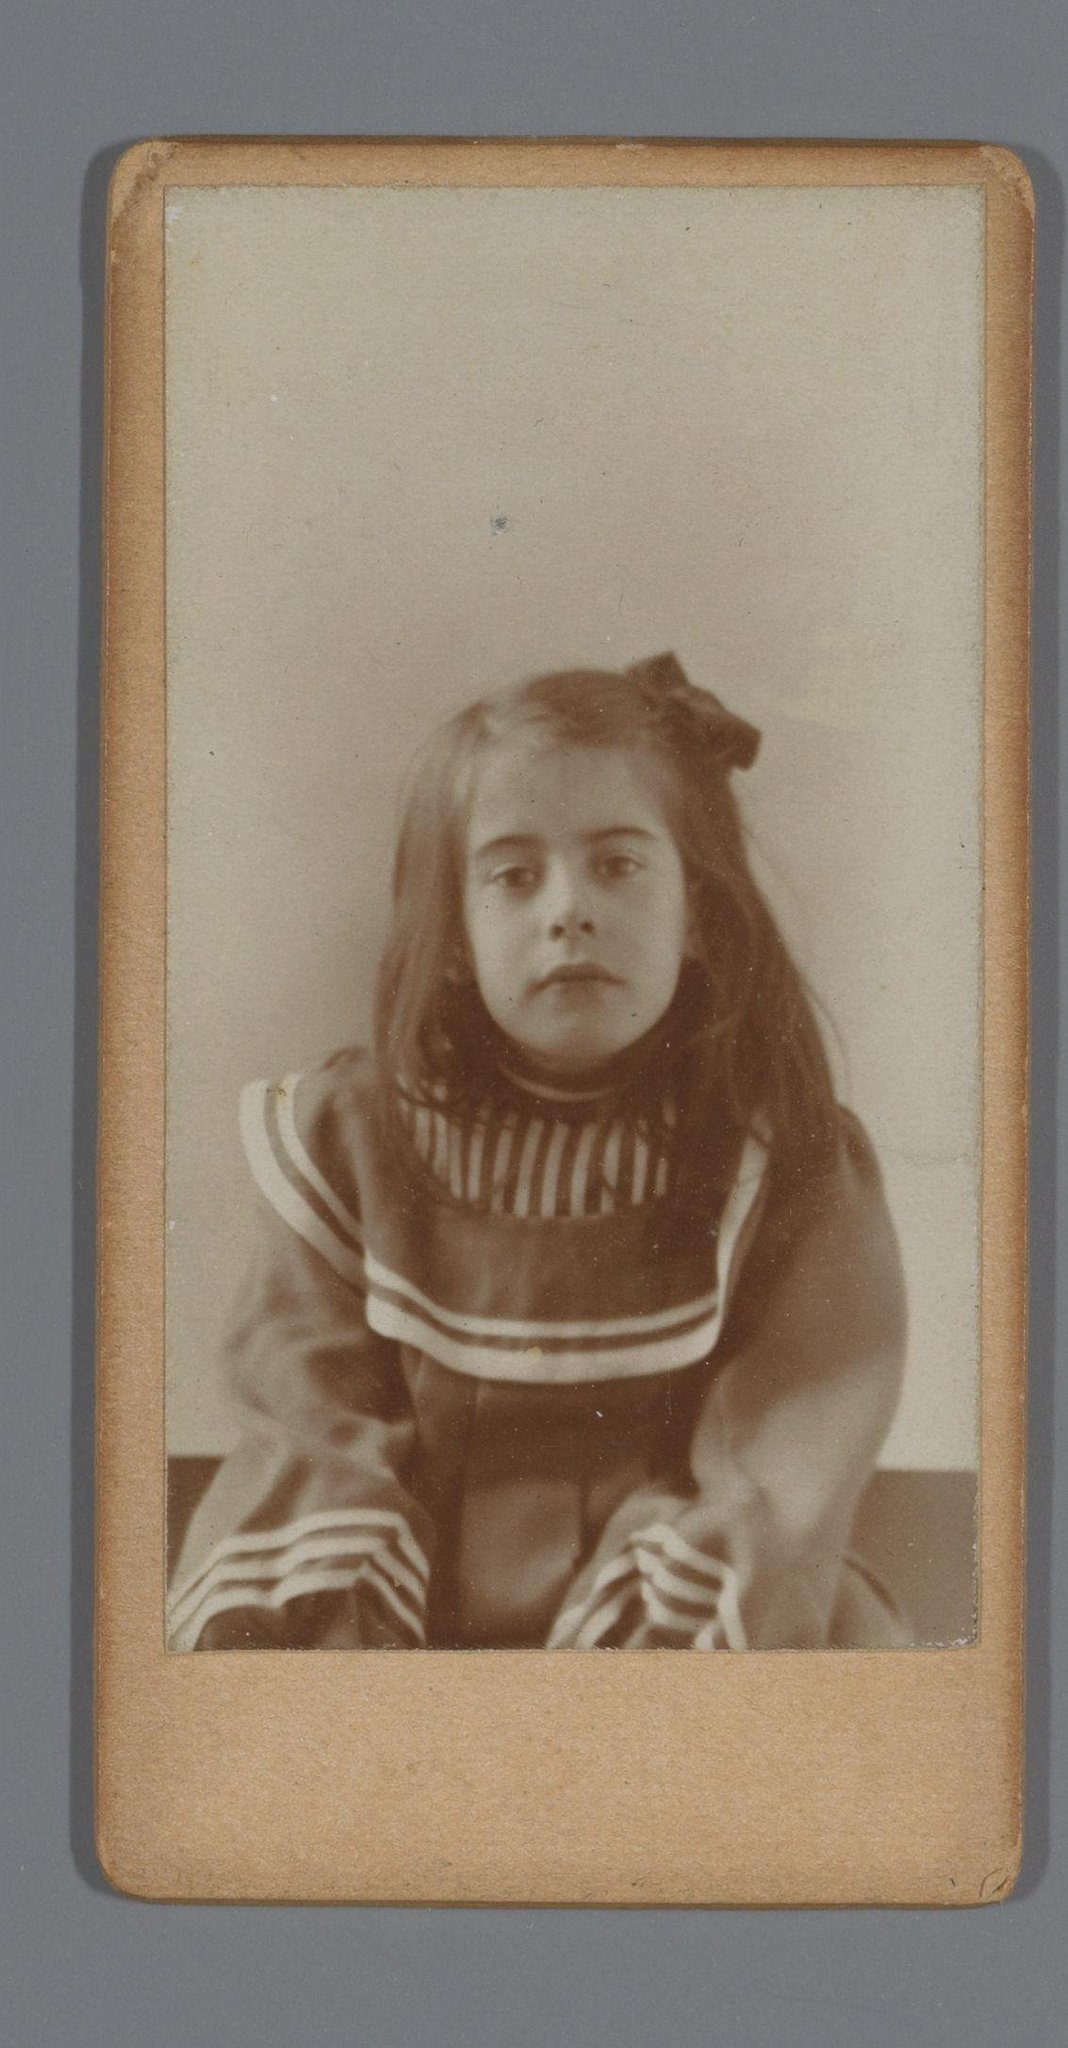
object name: photograph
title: Portret van een onbekend meisje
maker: Anonymous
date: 1900-1915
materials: cardboard, photographic support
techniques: gelatin silver print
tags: girl (child between toddler and youth)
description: Hetzelfde meisje is gefotografeerd in RP-F-F20608.